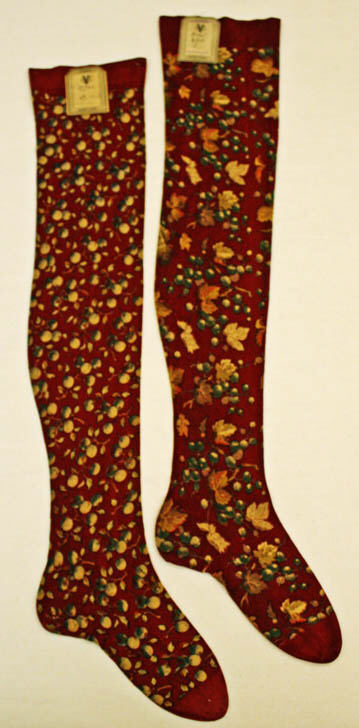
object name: stocking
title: Stockings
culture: french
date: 1873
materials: cotton